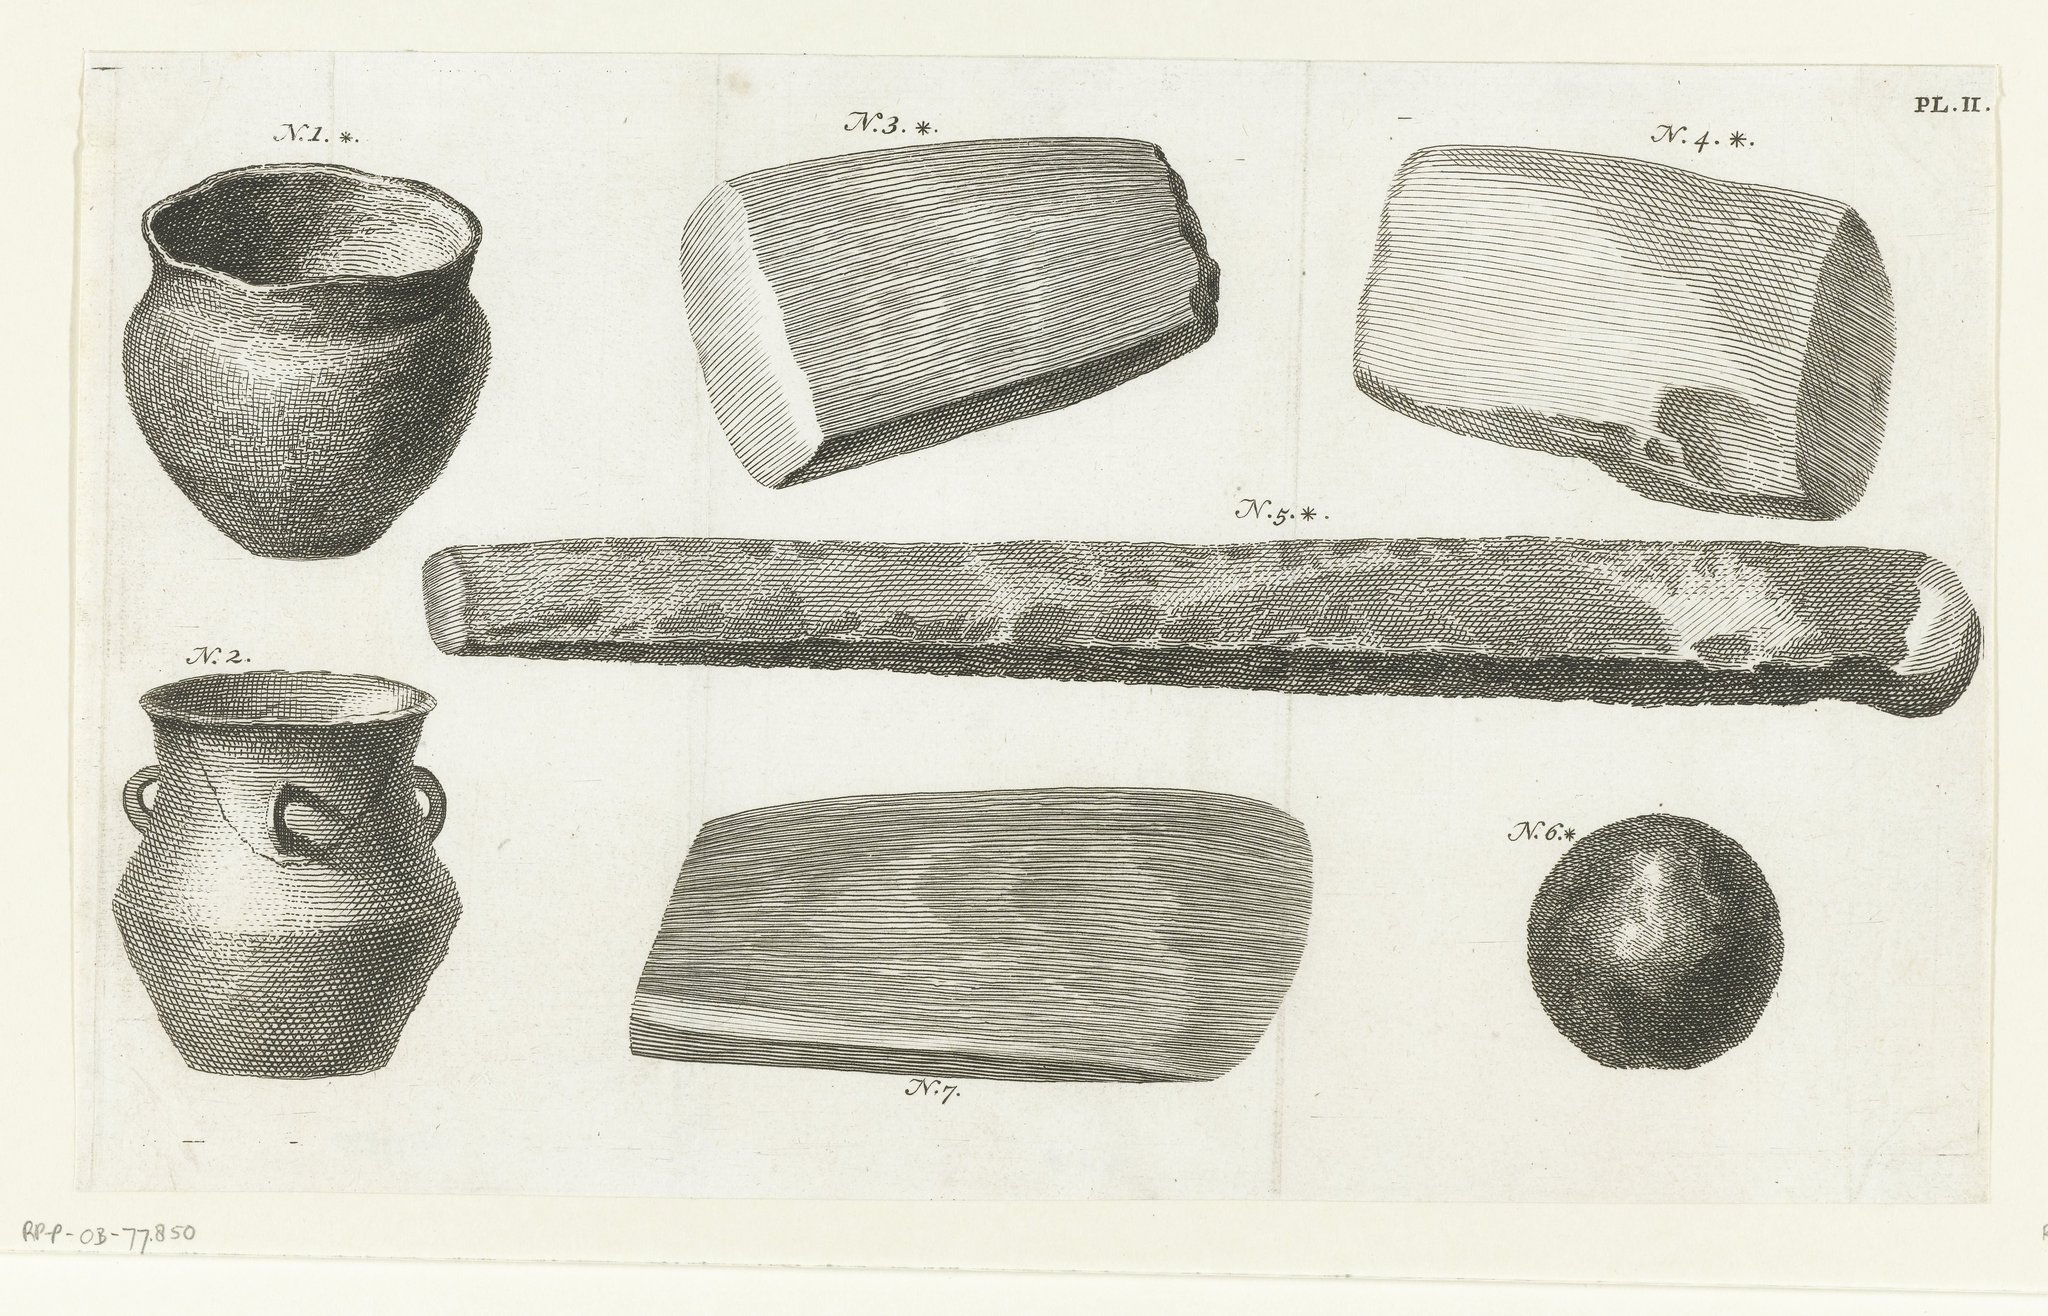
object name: print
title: Voorwerpen uit een grafkelder bij Eext, pl. II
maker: Anonymous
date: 1758-1760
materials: paper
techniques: etching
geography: netherlands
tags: eext, prehistorie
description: Illustratie voor: Joannes van Lier, Oudheidkundige brieven : bevattende eene verhandeling over de manier van begraven, en over de lykbusschen, wapenen, veld- en eertekens, der oude Germanen, en in het byzonder de beschryving van eenen alouden steenen grafkelder, met de daarin gevondene lykbusschen, donderkeilen en donderbylen, enz. by het boerschap Eext, in het landschap Drenthe, Pieter van Thol, ’s-Gravenhage 1760. Plaat II.